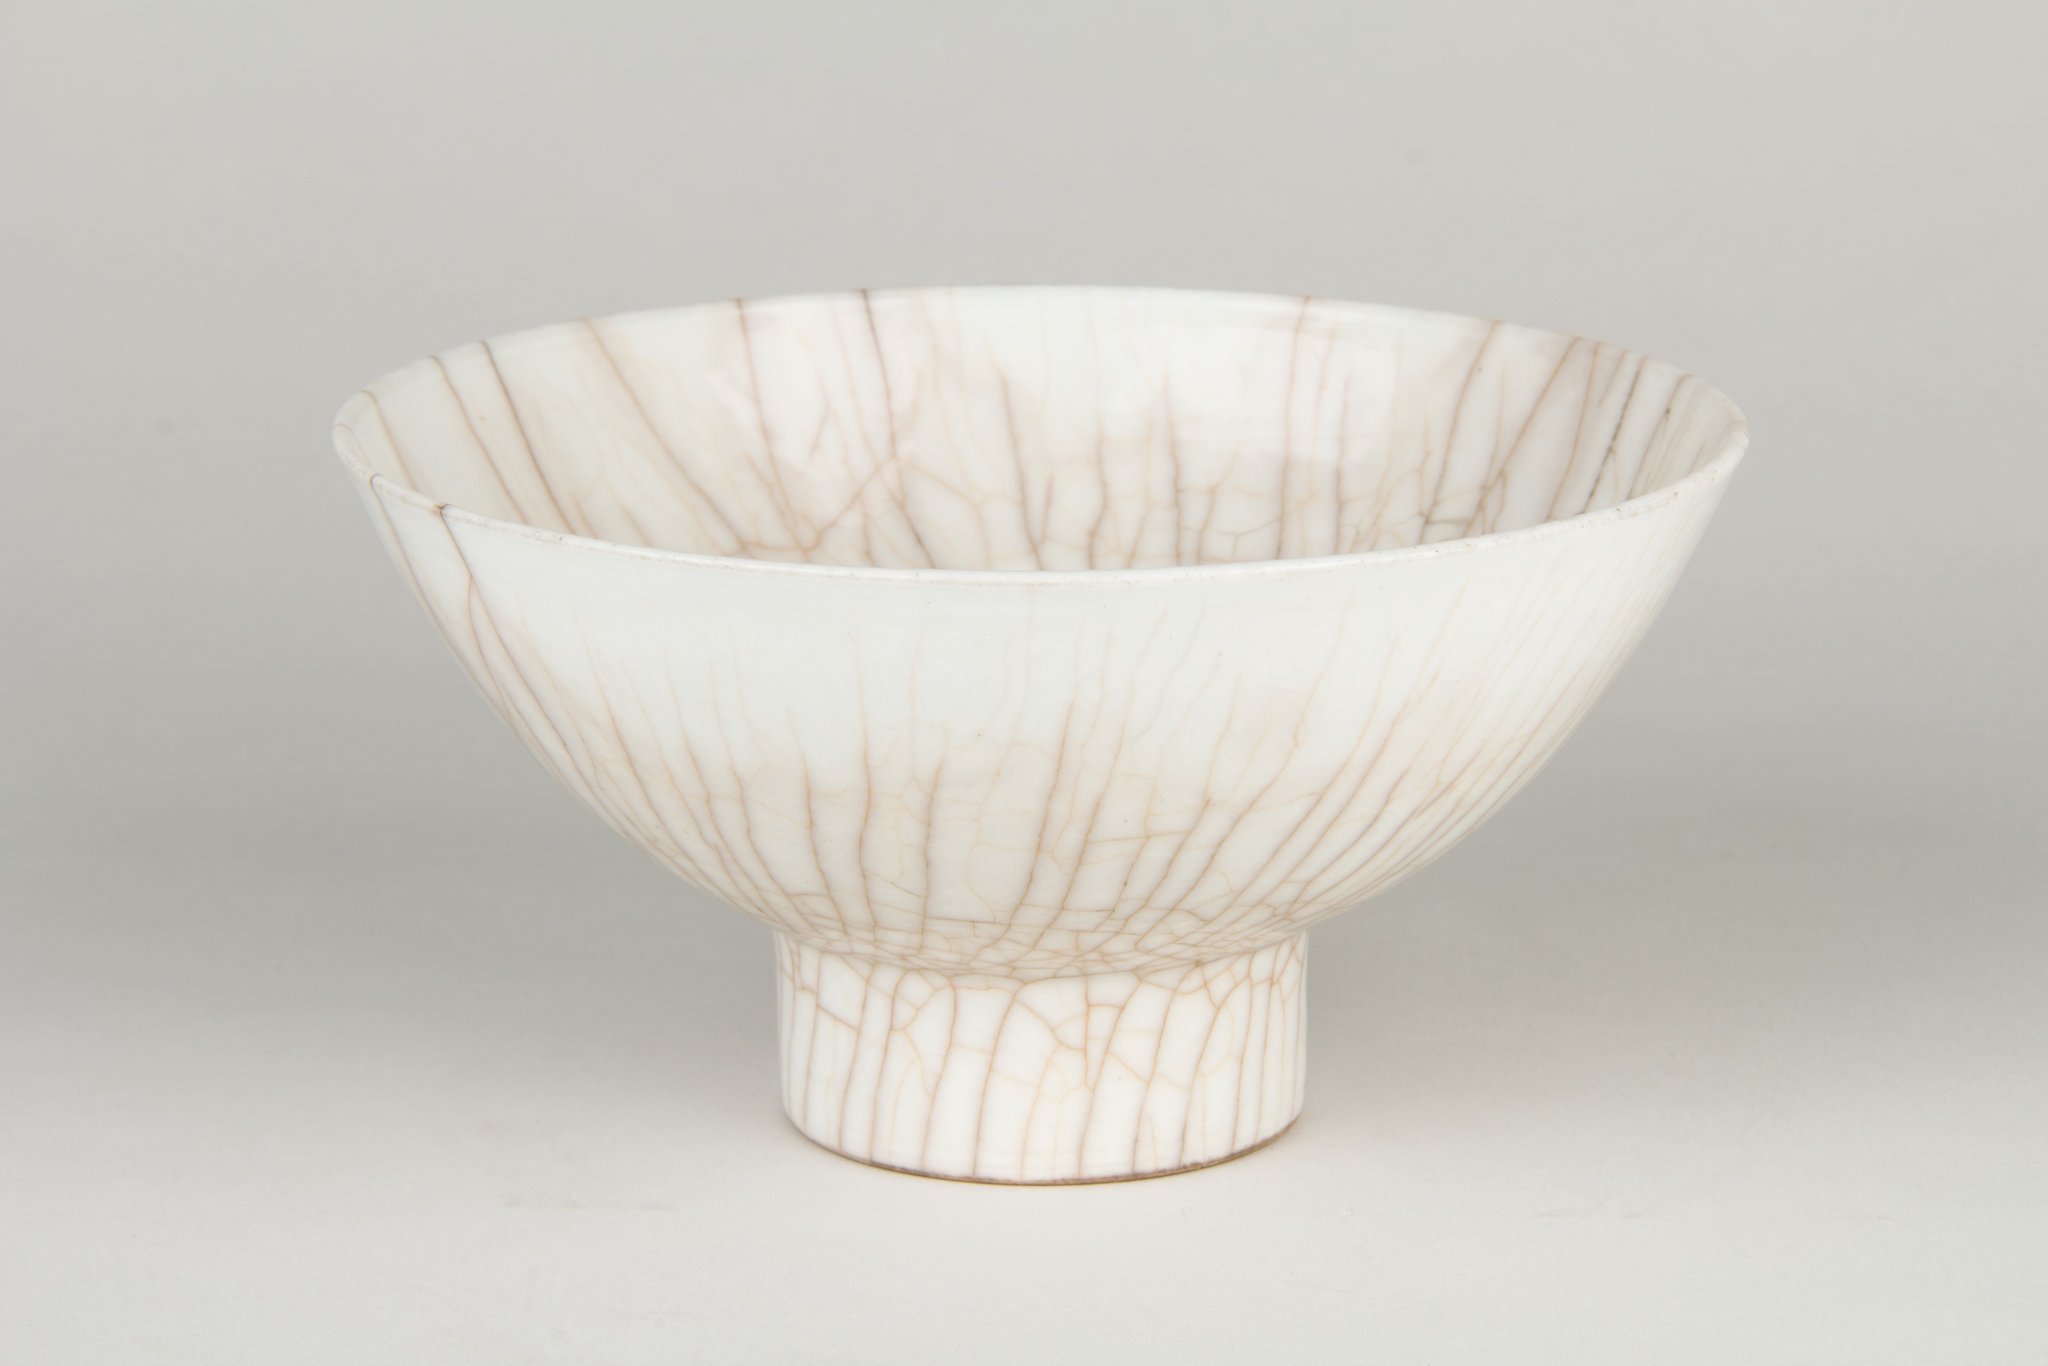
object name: cup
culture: chinese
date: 1801-1900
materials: porcelain